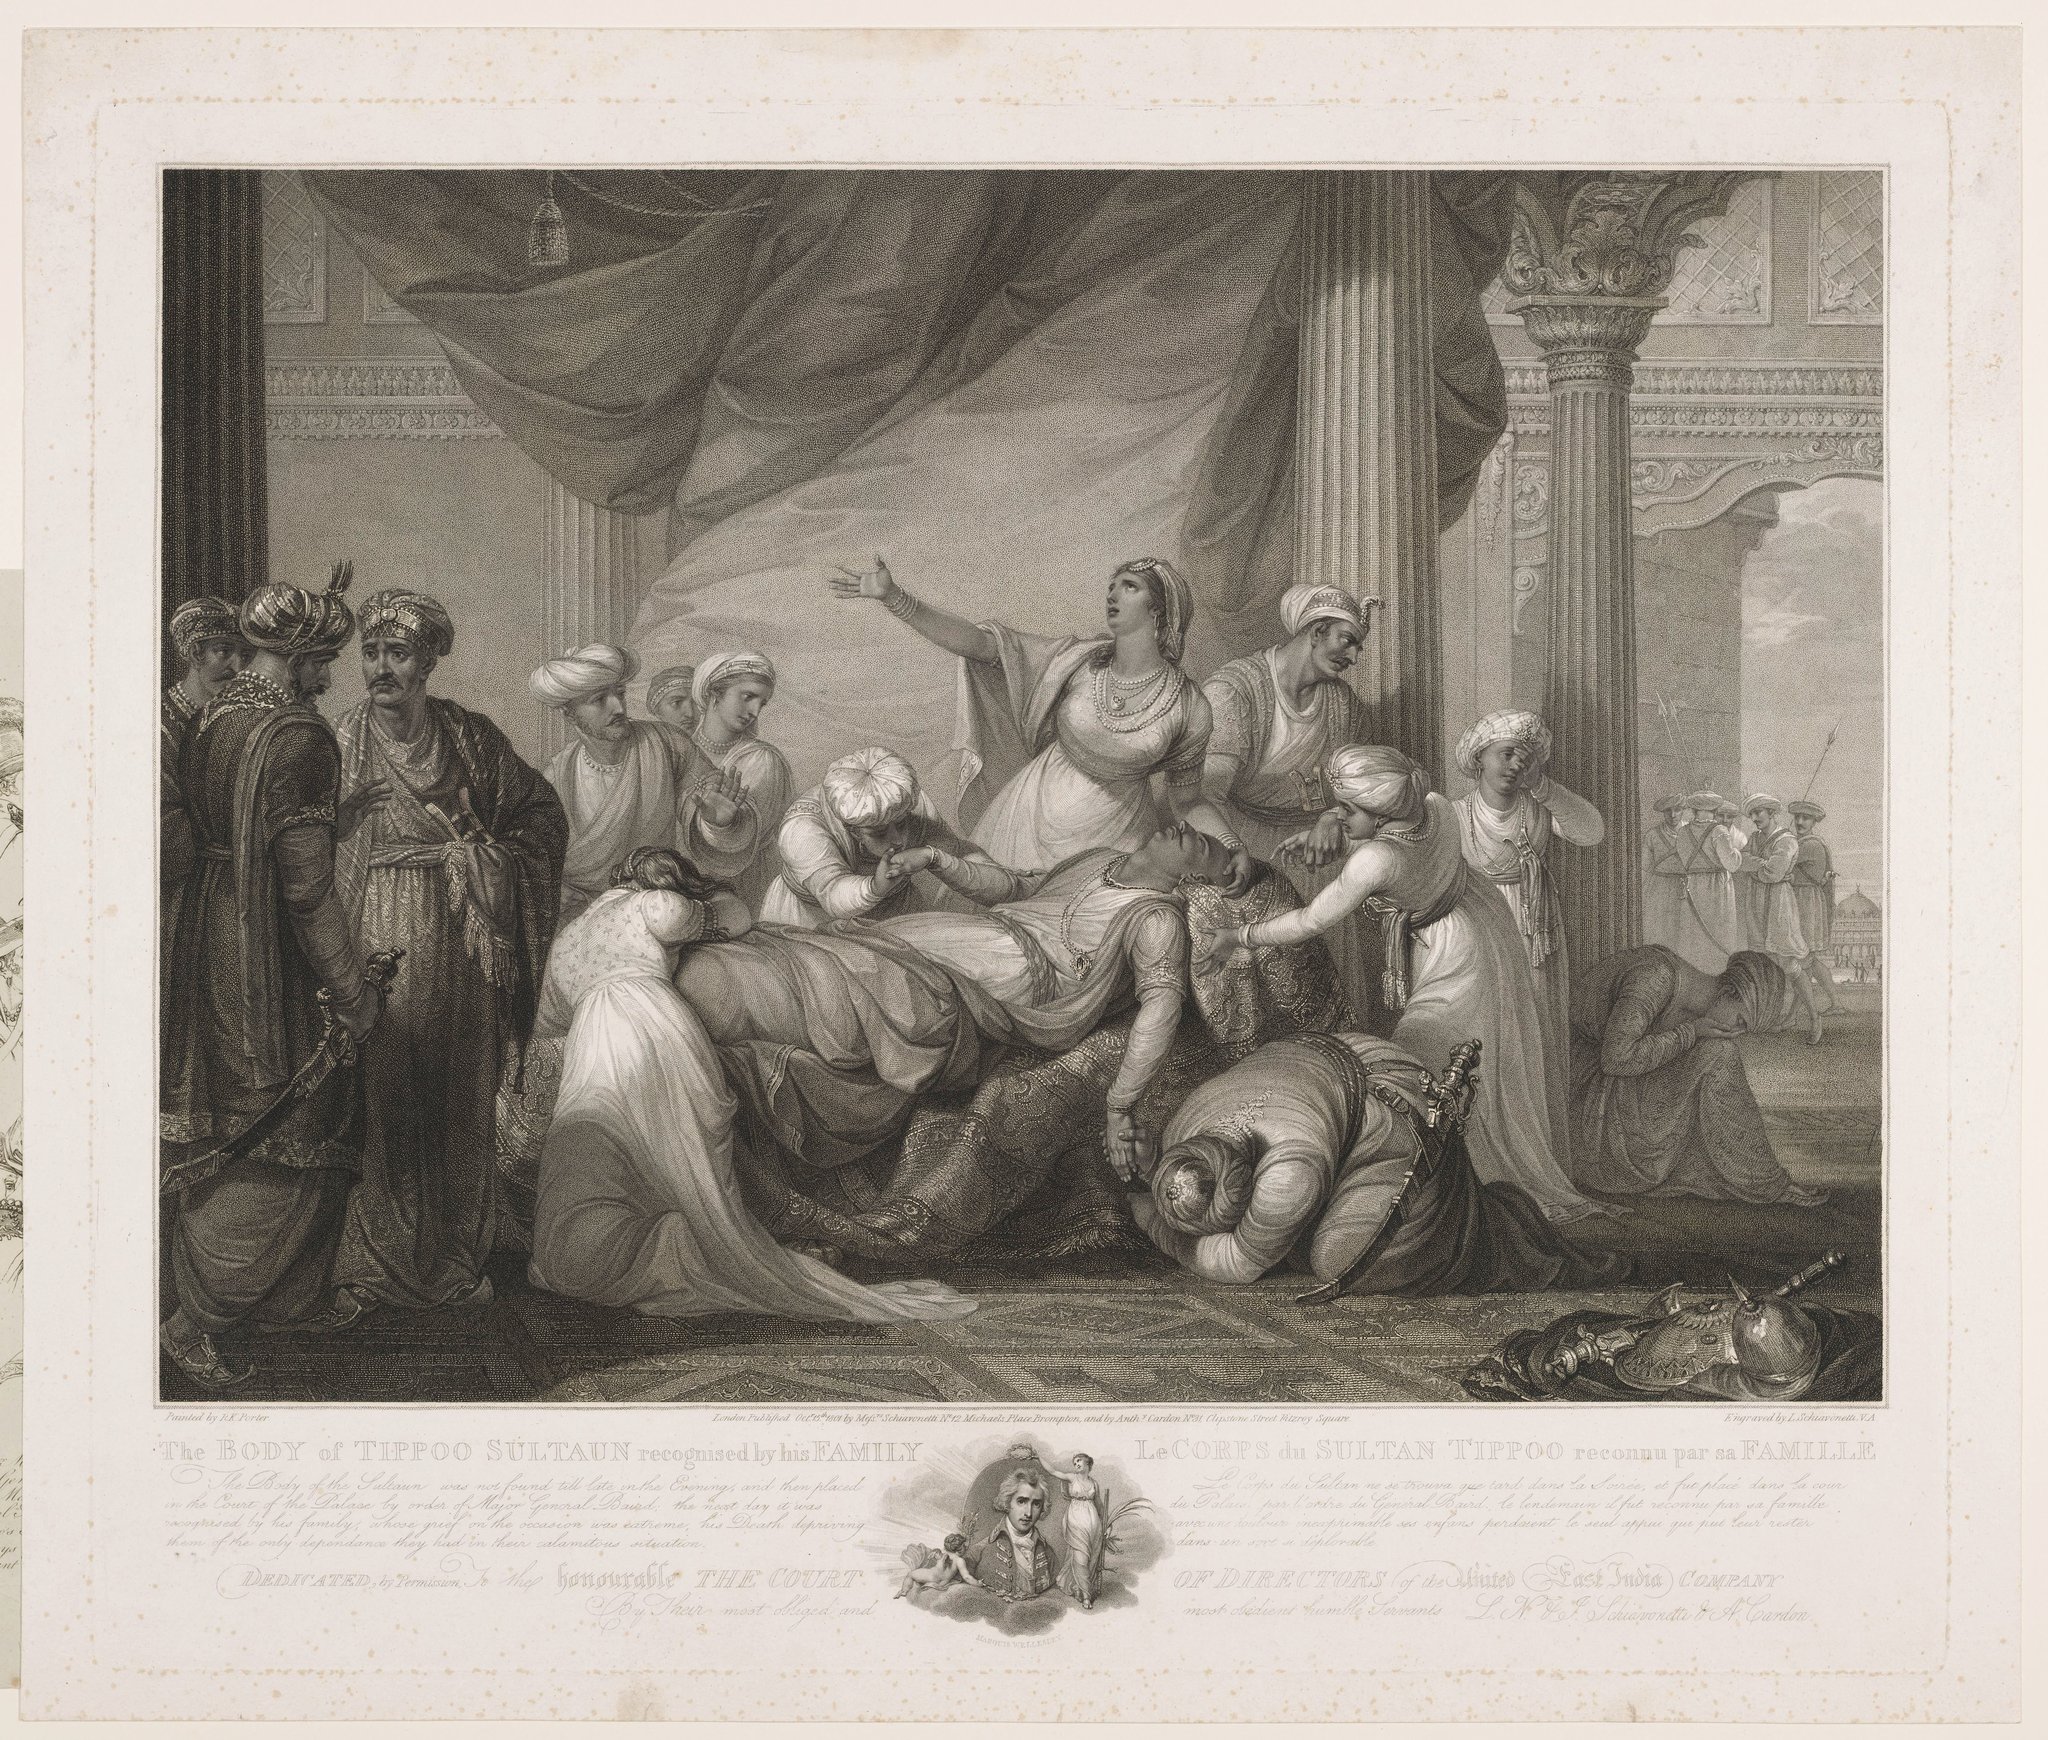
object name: print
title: The body of Tippoo Sultaun recognised by his family / Le corps du Sultan Tippoo reconnu par sa famille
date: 1775-1810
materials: paper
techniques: etching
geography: london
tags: mourning customs, ruler, sovereign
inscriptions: collector's mark: Lugt Lugt, collector's mark: Lugt Lugt, collector's mark: Lugt 12, collector's mark: Lugt 2165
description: Zicht in een paleiszaal waar de familie van Sultan Tippoo treurend rond zijn lichaam zit. Titel, tekst, opracht en portret in ondermarge.